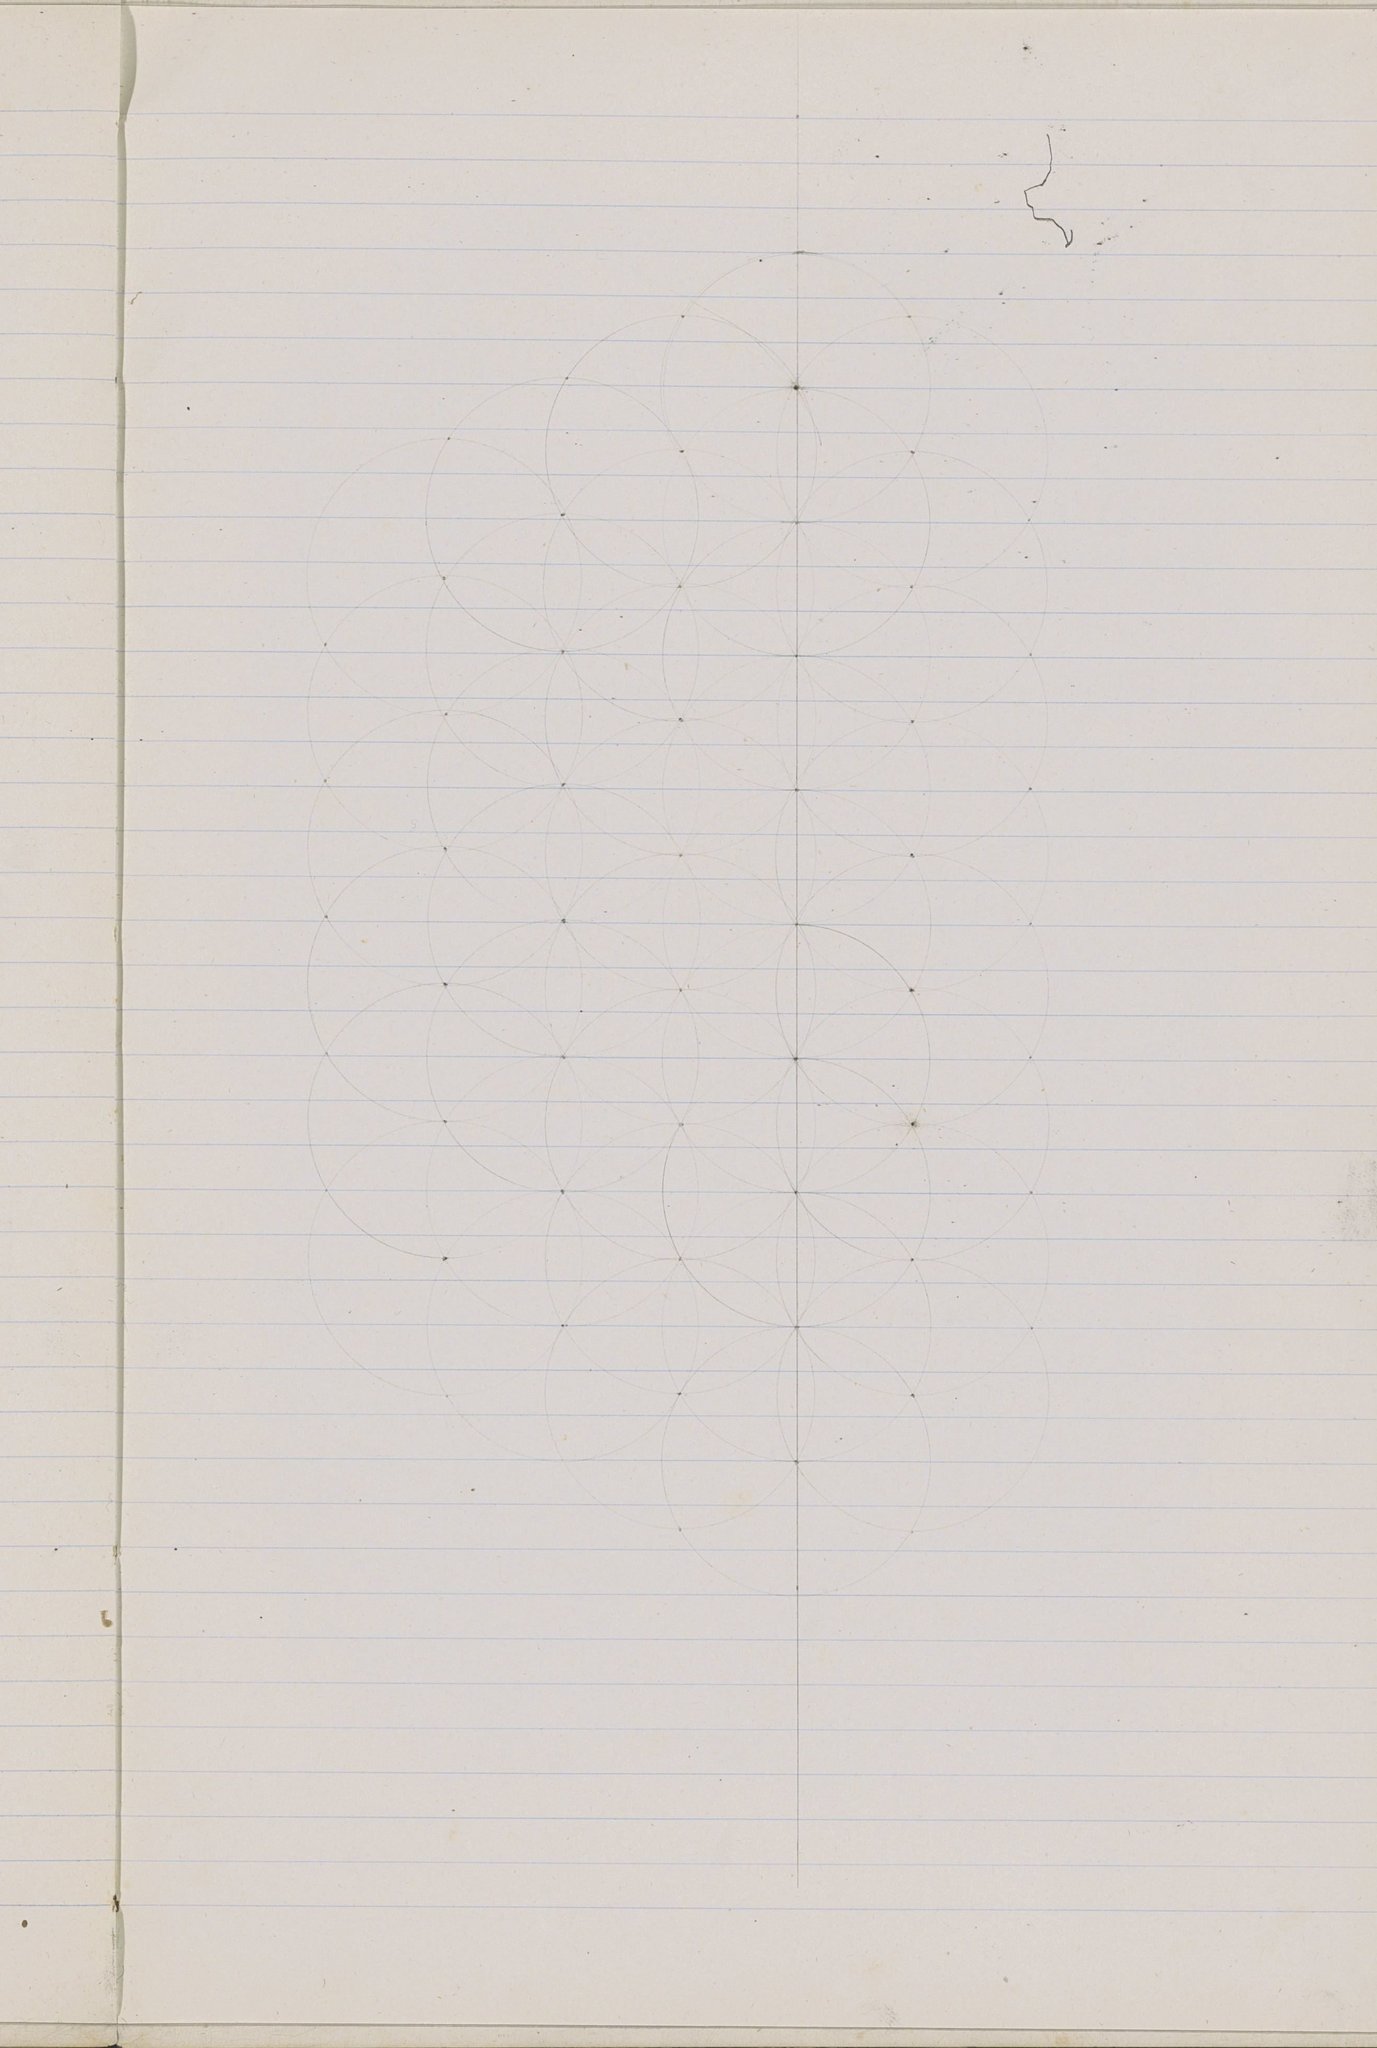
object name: sketchbook leaf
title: Ornament met overlappende cirkels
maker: gerrit willem dijsselhof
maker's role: designer, draughtsman, print maker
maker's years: 1866-1924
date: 1901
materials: pencil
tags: ornament ~ circle and derived from circle, e.g.: guilloche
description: De overlappende cirkels vormen een bloemenpatroon. Blad 31 recto uit een schetsboek met 79 bladen.